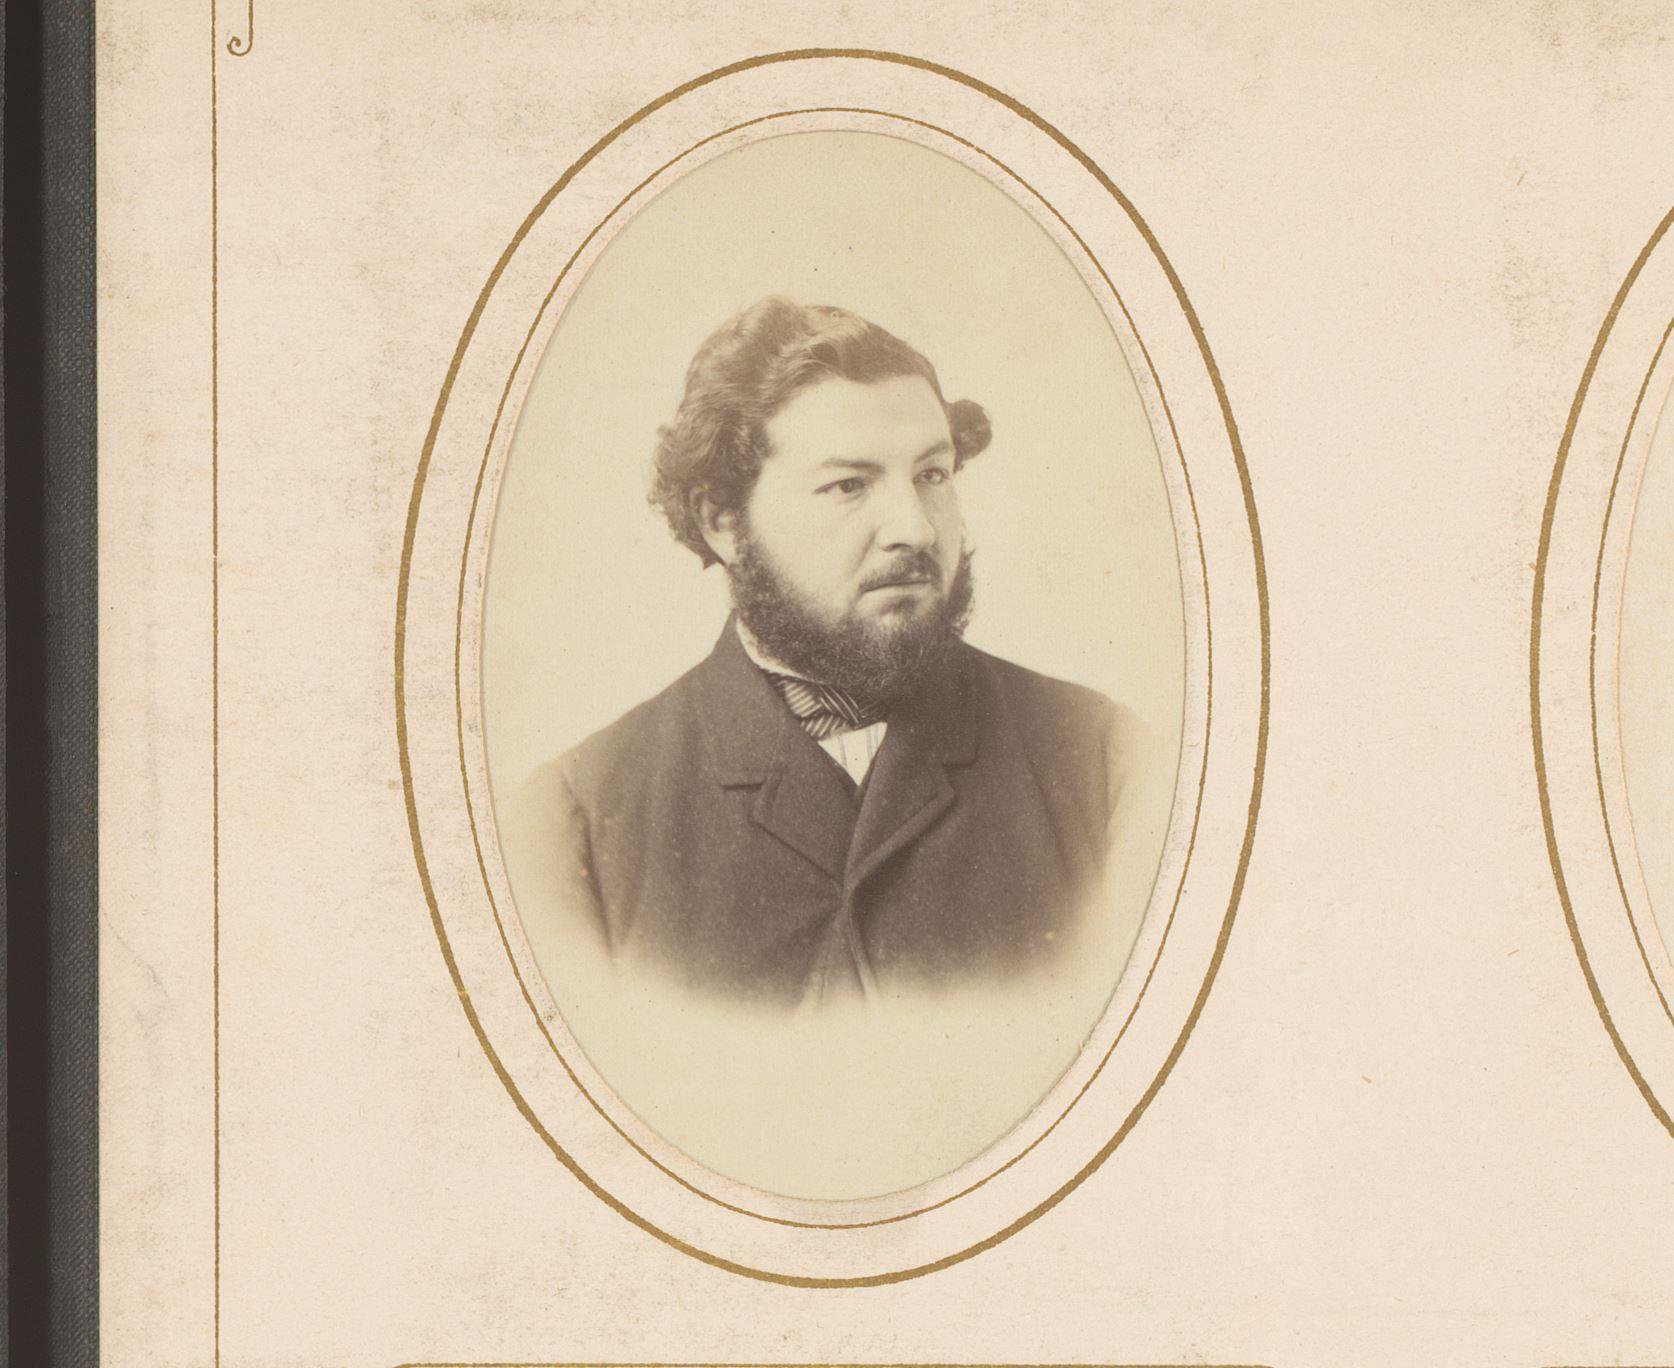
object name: album leaf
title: Portret van een man met snor en baard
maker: françois gaillard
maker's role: fotograaf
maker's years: 1802-1875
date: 1865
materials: cardboard, photographic support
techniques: albumen print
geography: brussels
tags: moustache, historical persons, beard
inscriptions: inscription: ‘GAILLARD/ PHOTOGRAPHE/ RUE DES FRIPIERS, 36./ BRUXELLES’